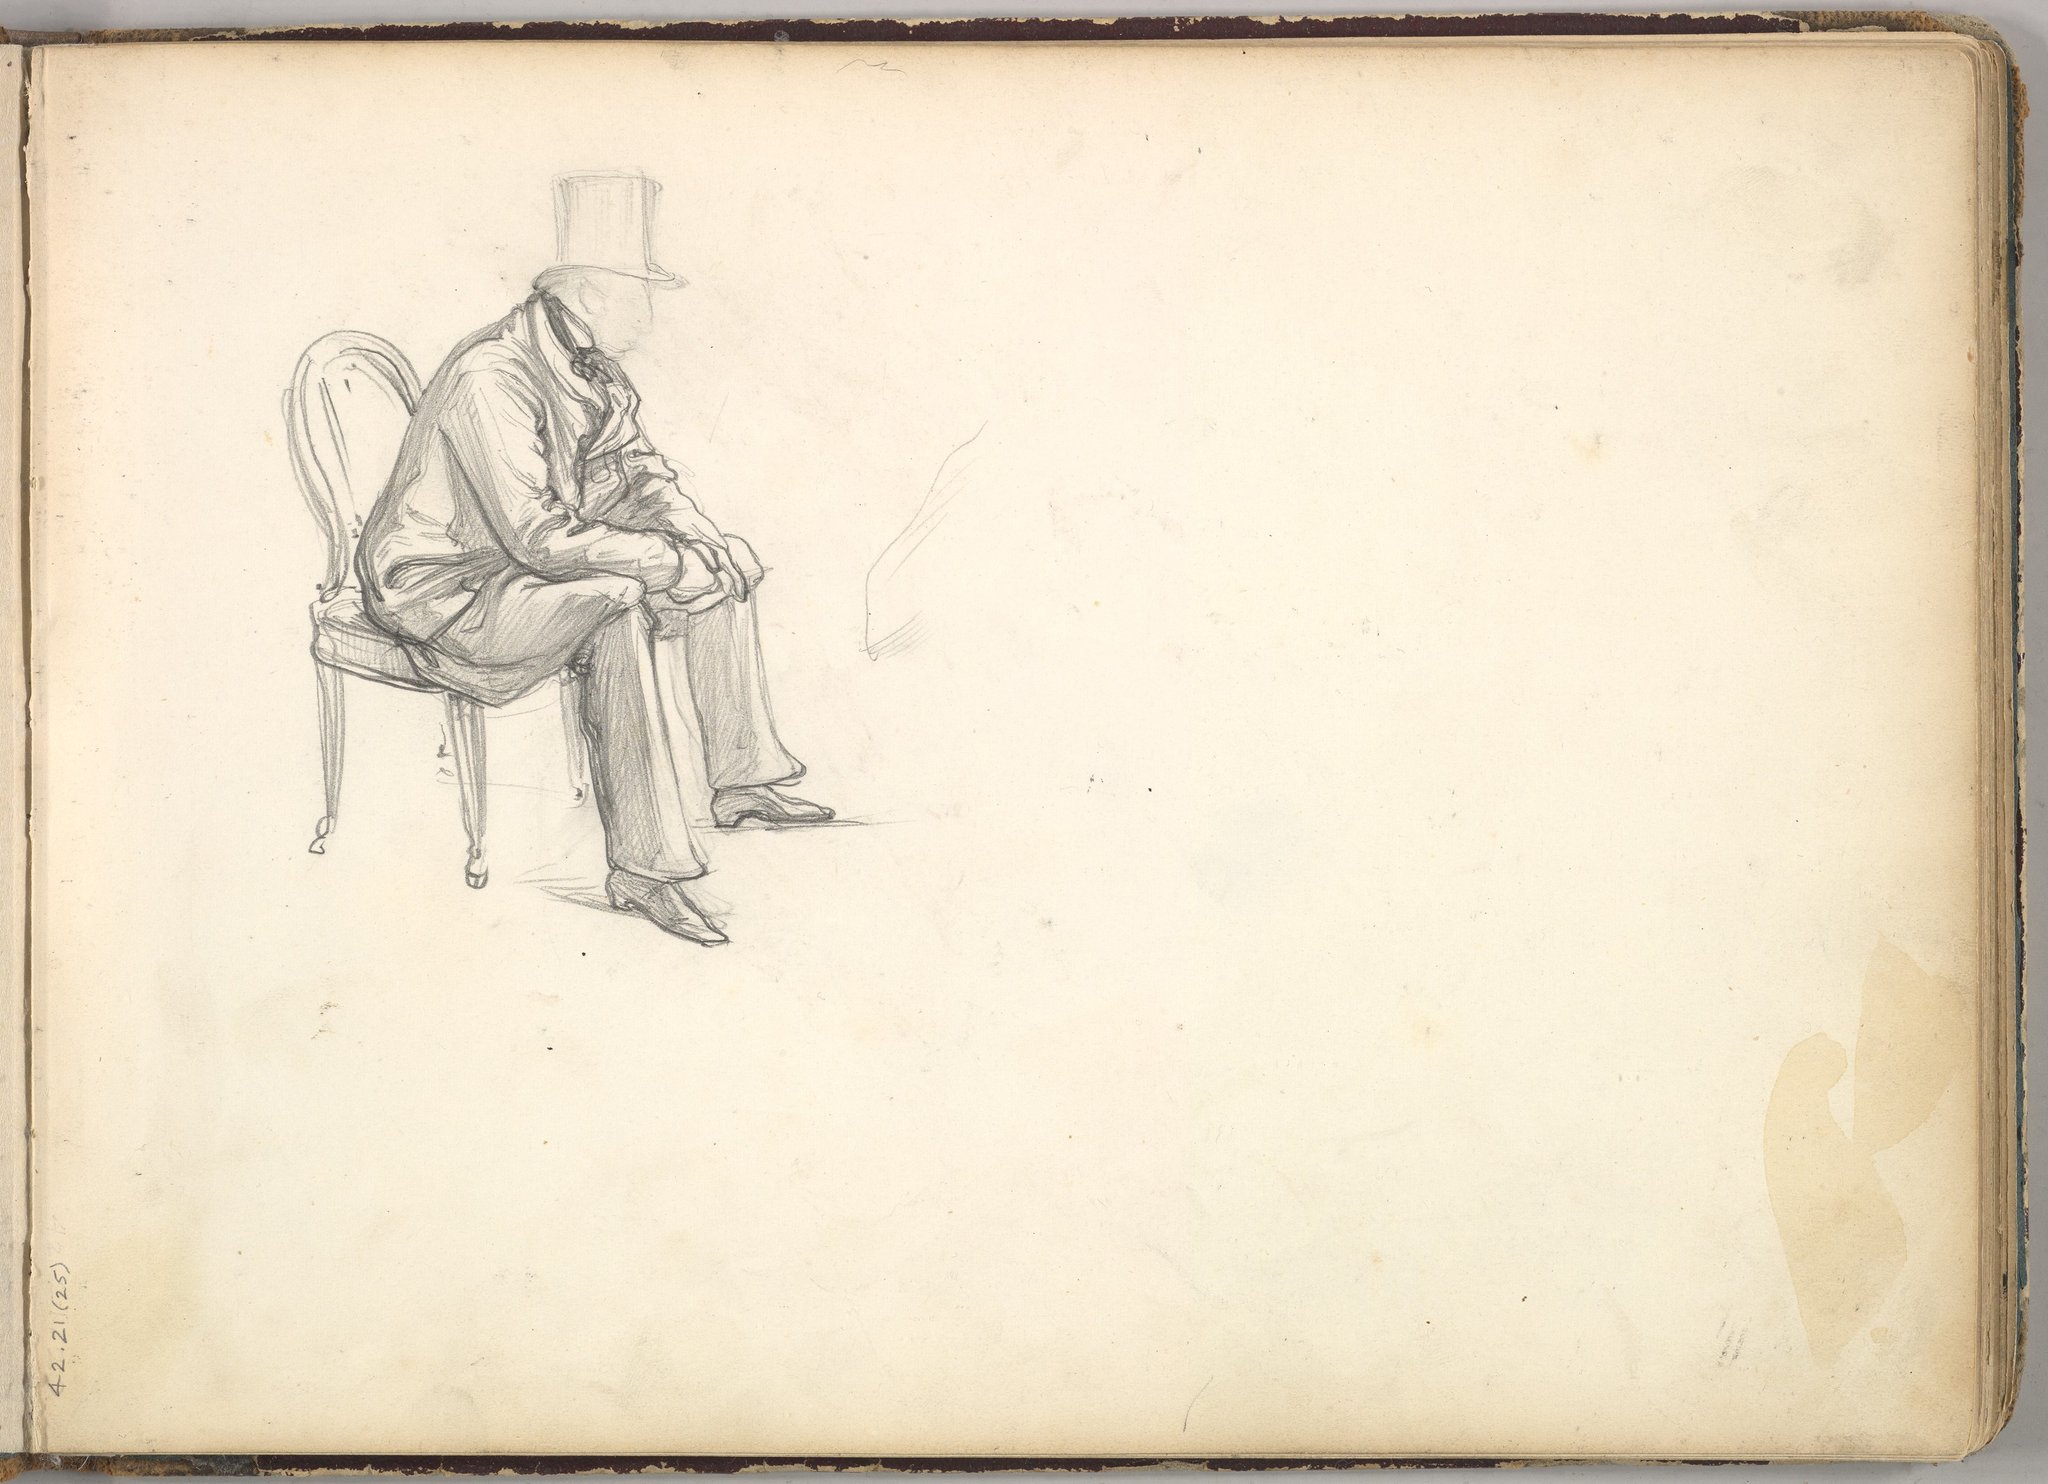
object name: drawing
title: Man Seated on a Chair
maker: frederic, lord leighton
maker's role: artist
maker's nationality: british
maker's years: 1830-1896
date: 1855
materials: graphite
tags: men